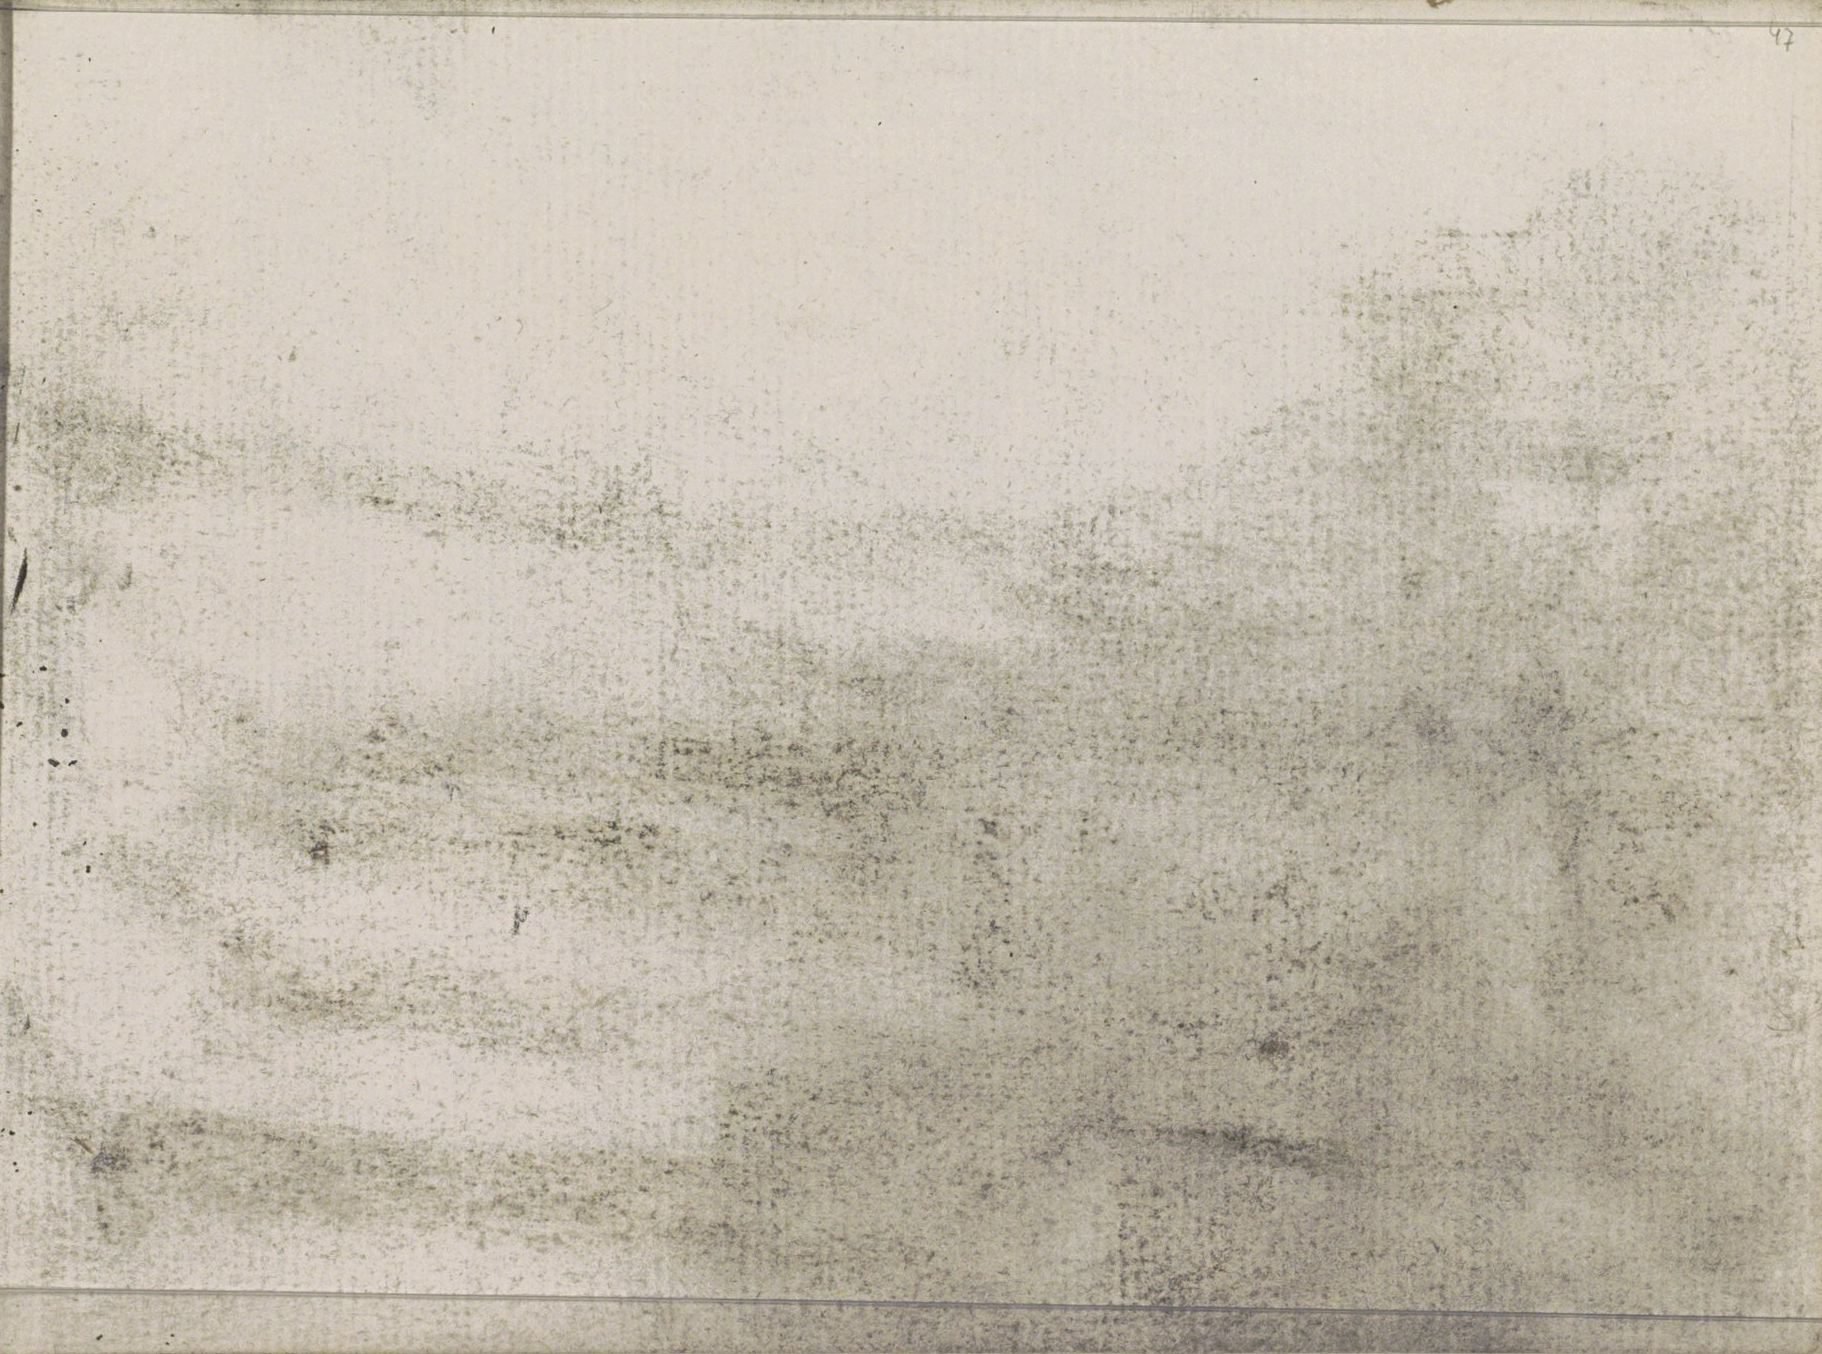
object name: sketchbook leaf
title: Abklatsch van de krijttekening op pagina 46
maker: isaac israels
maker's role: draughtsman, painter, print maker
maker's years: 1865-1934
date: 1886-1903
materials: paper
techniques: printmaking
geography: amsterdam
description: Pagina 47 uit schetsboek XLVII met 52 pagina's.